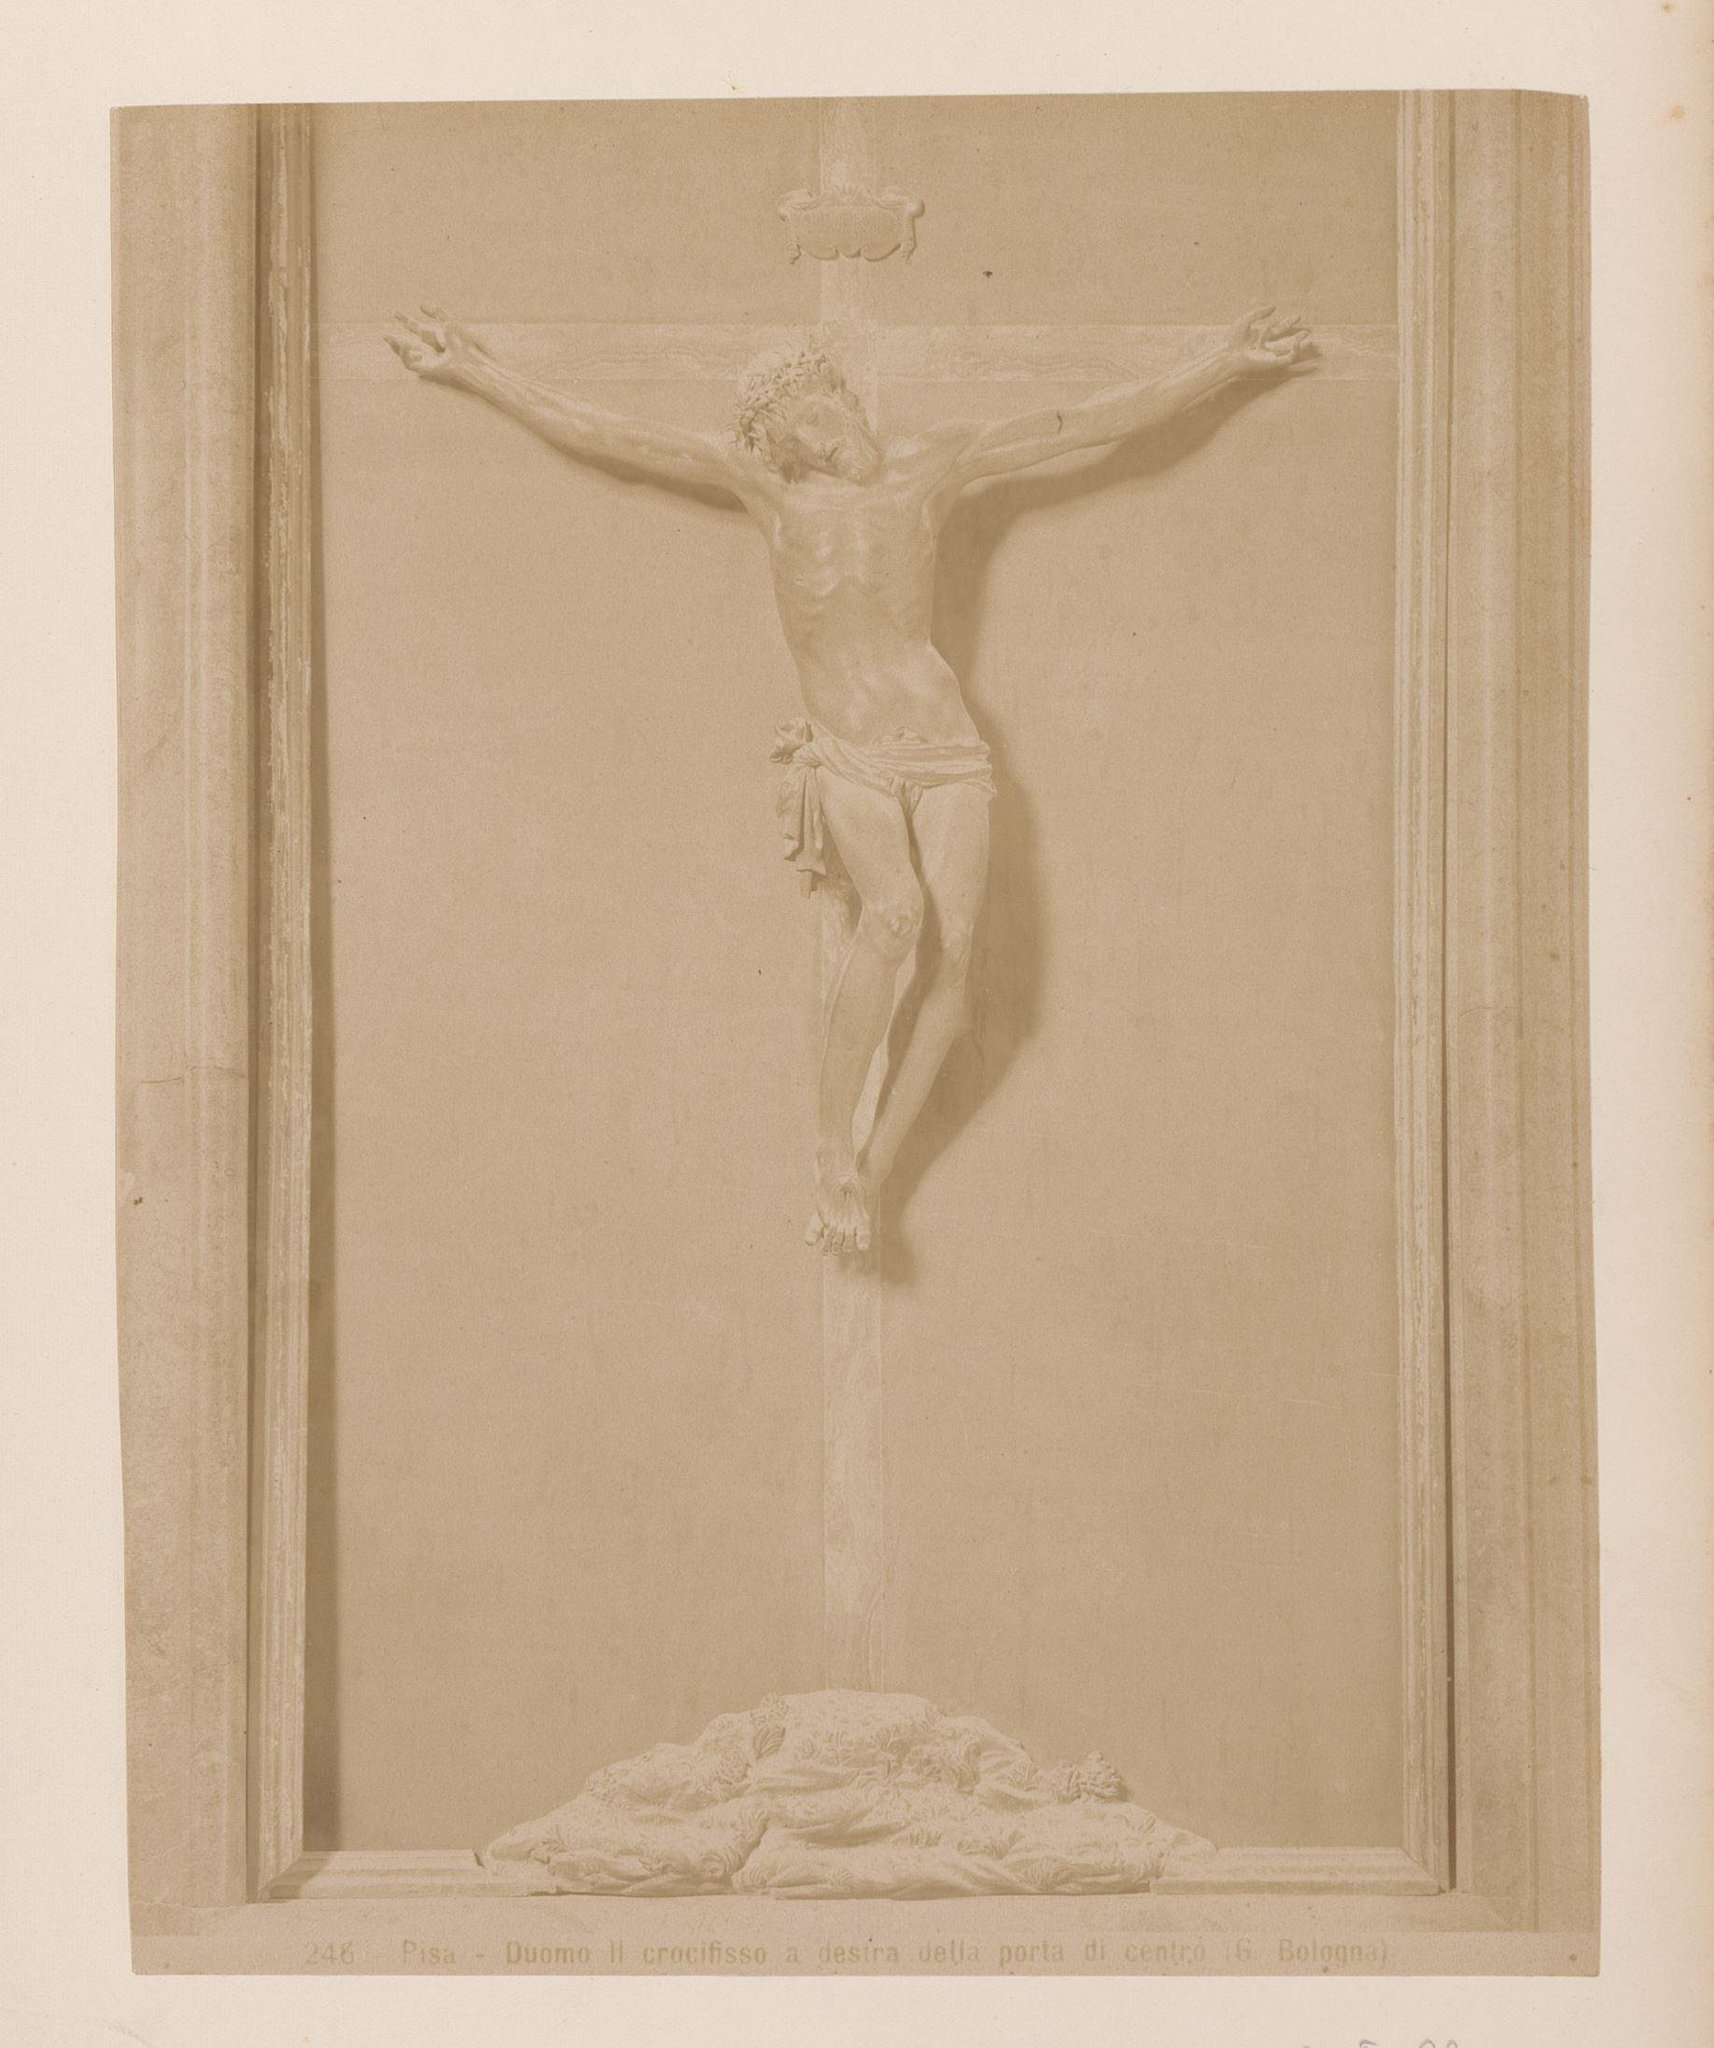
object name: album leaf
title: Sculptuur van een kruisiging naar Giambologna op een deur van de Dom van Pisa, Italië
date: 1860-1881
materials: paper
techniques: albumen print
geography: pisa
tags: piece of sculpture, reproduction of a piece of sculpture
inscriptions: number: ‘246’